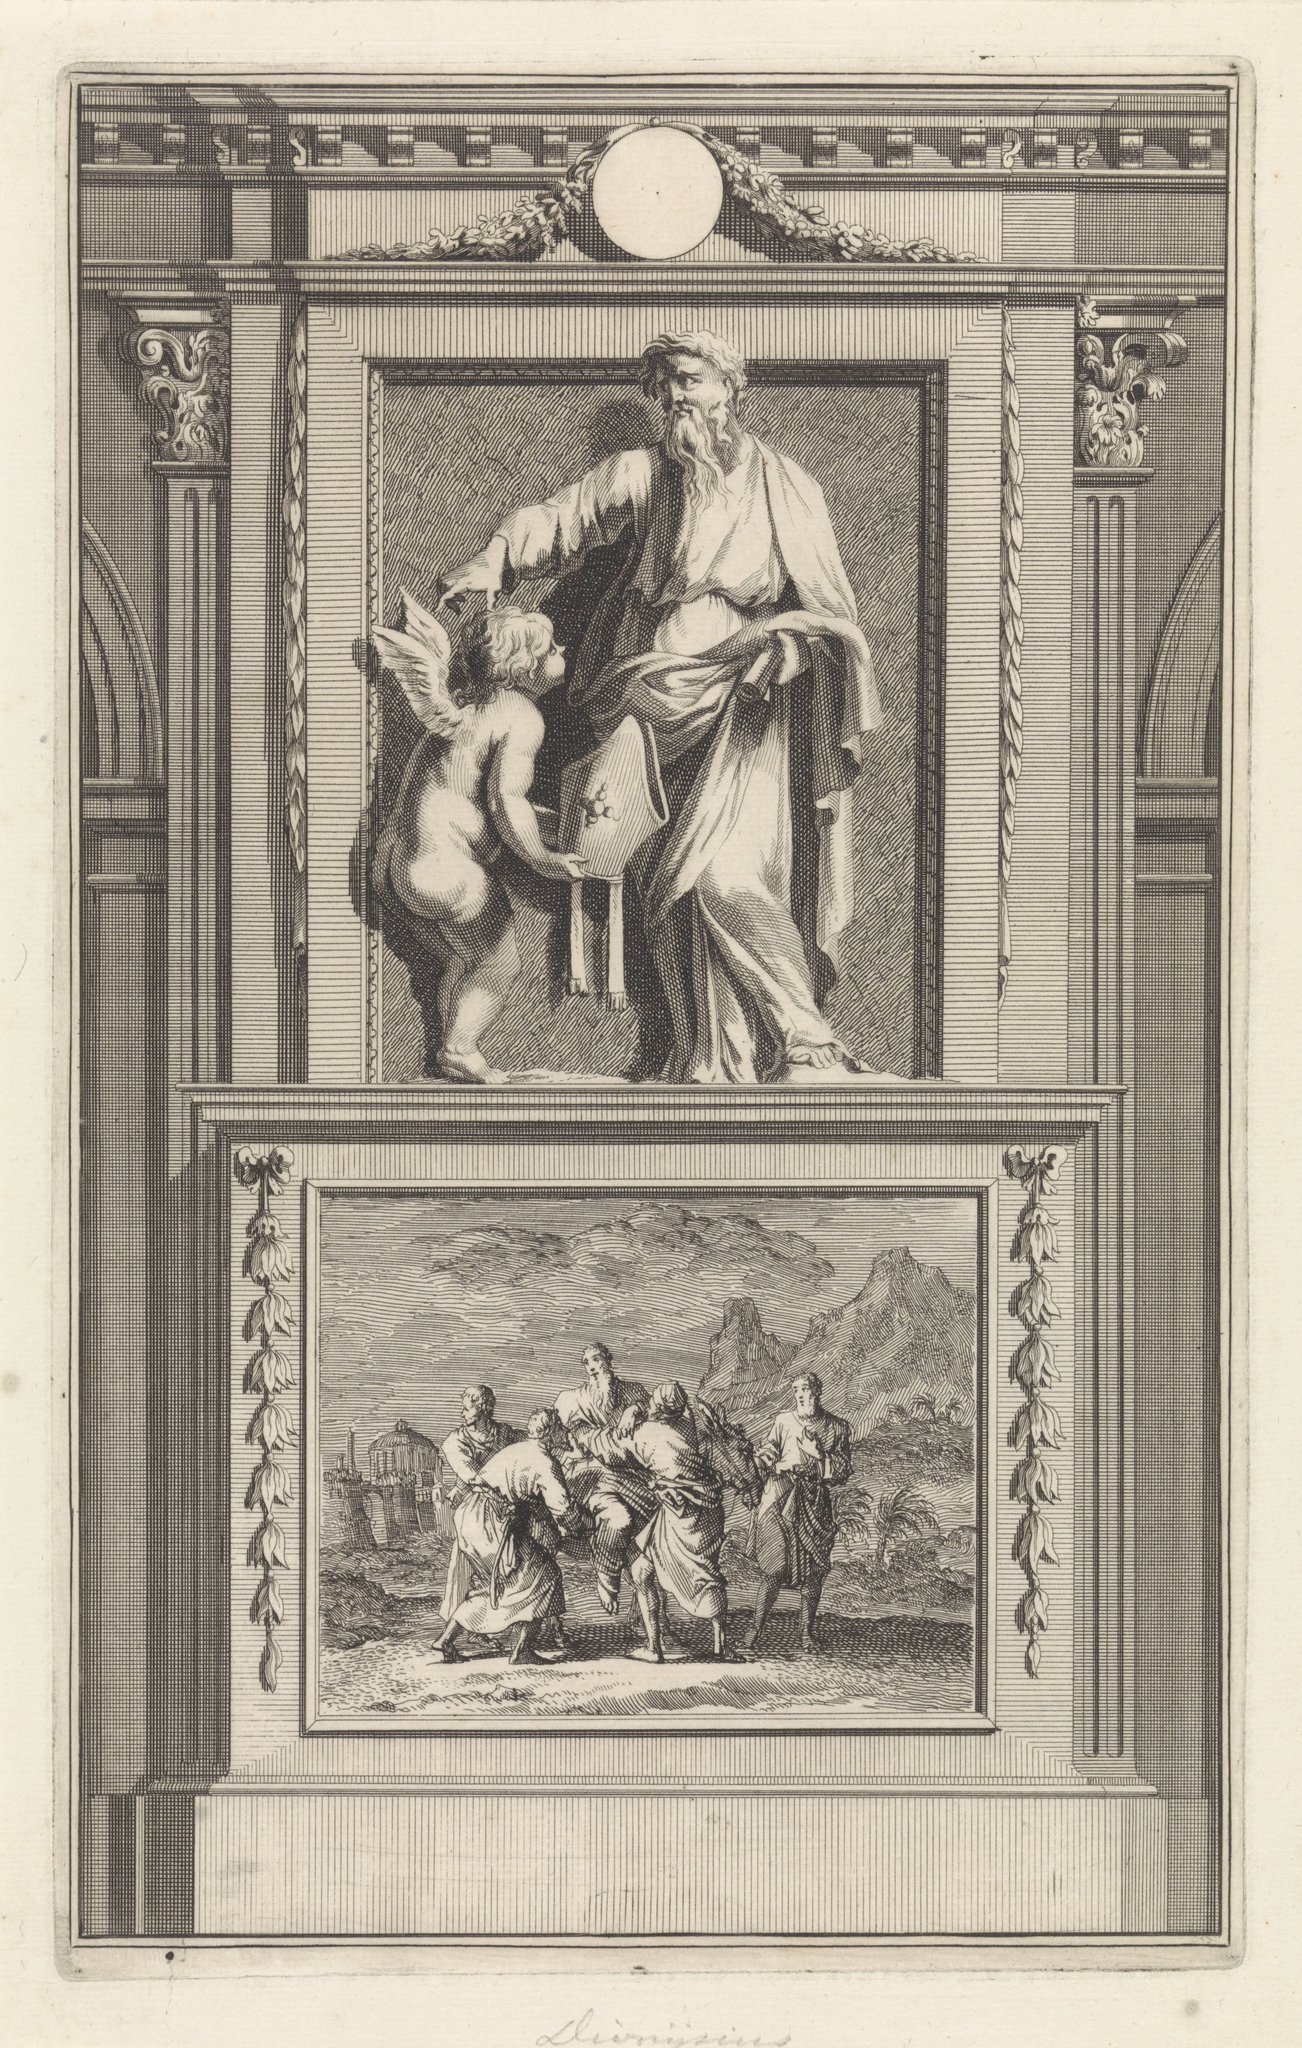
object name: print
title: H. Dionysius van Alexandrië, kerkvader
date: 1698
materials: paper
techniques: engraving, etching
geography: amsterdam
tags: riding a horse, ass, or mule; rider, horseman, male saints (dionysius of alexandria)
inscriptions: collector's mark: Lugt 2228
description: De heilige kerkvader Dionysius van Alexandrië krijgt door een engel de bisschopsmijter aangeboden. Dionysius staat op een sokkel. Op de voorzijde de scène waarin hij door vier ouderlingen op een ezel wordt gezet om hem naar de Libische woestijn te brengen.